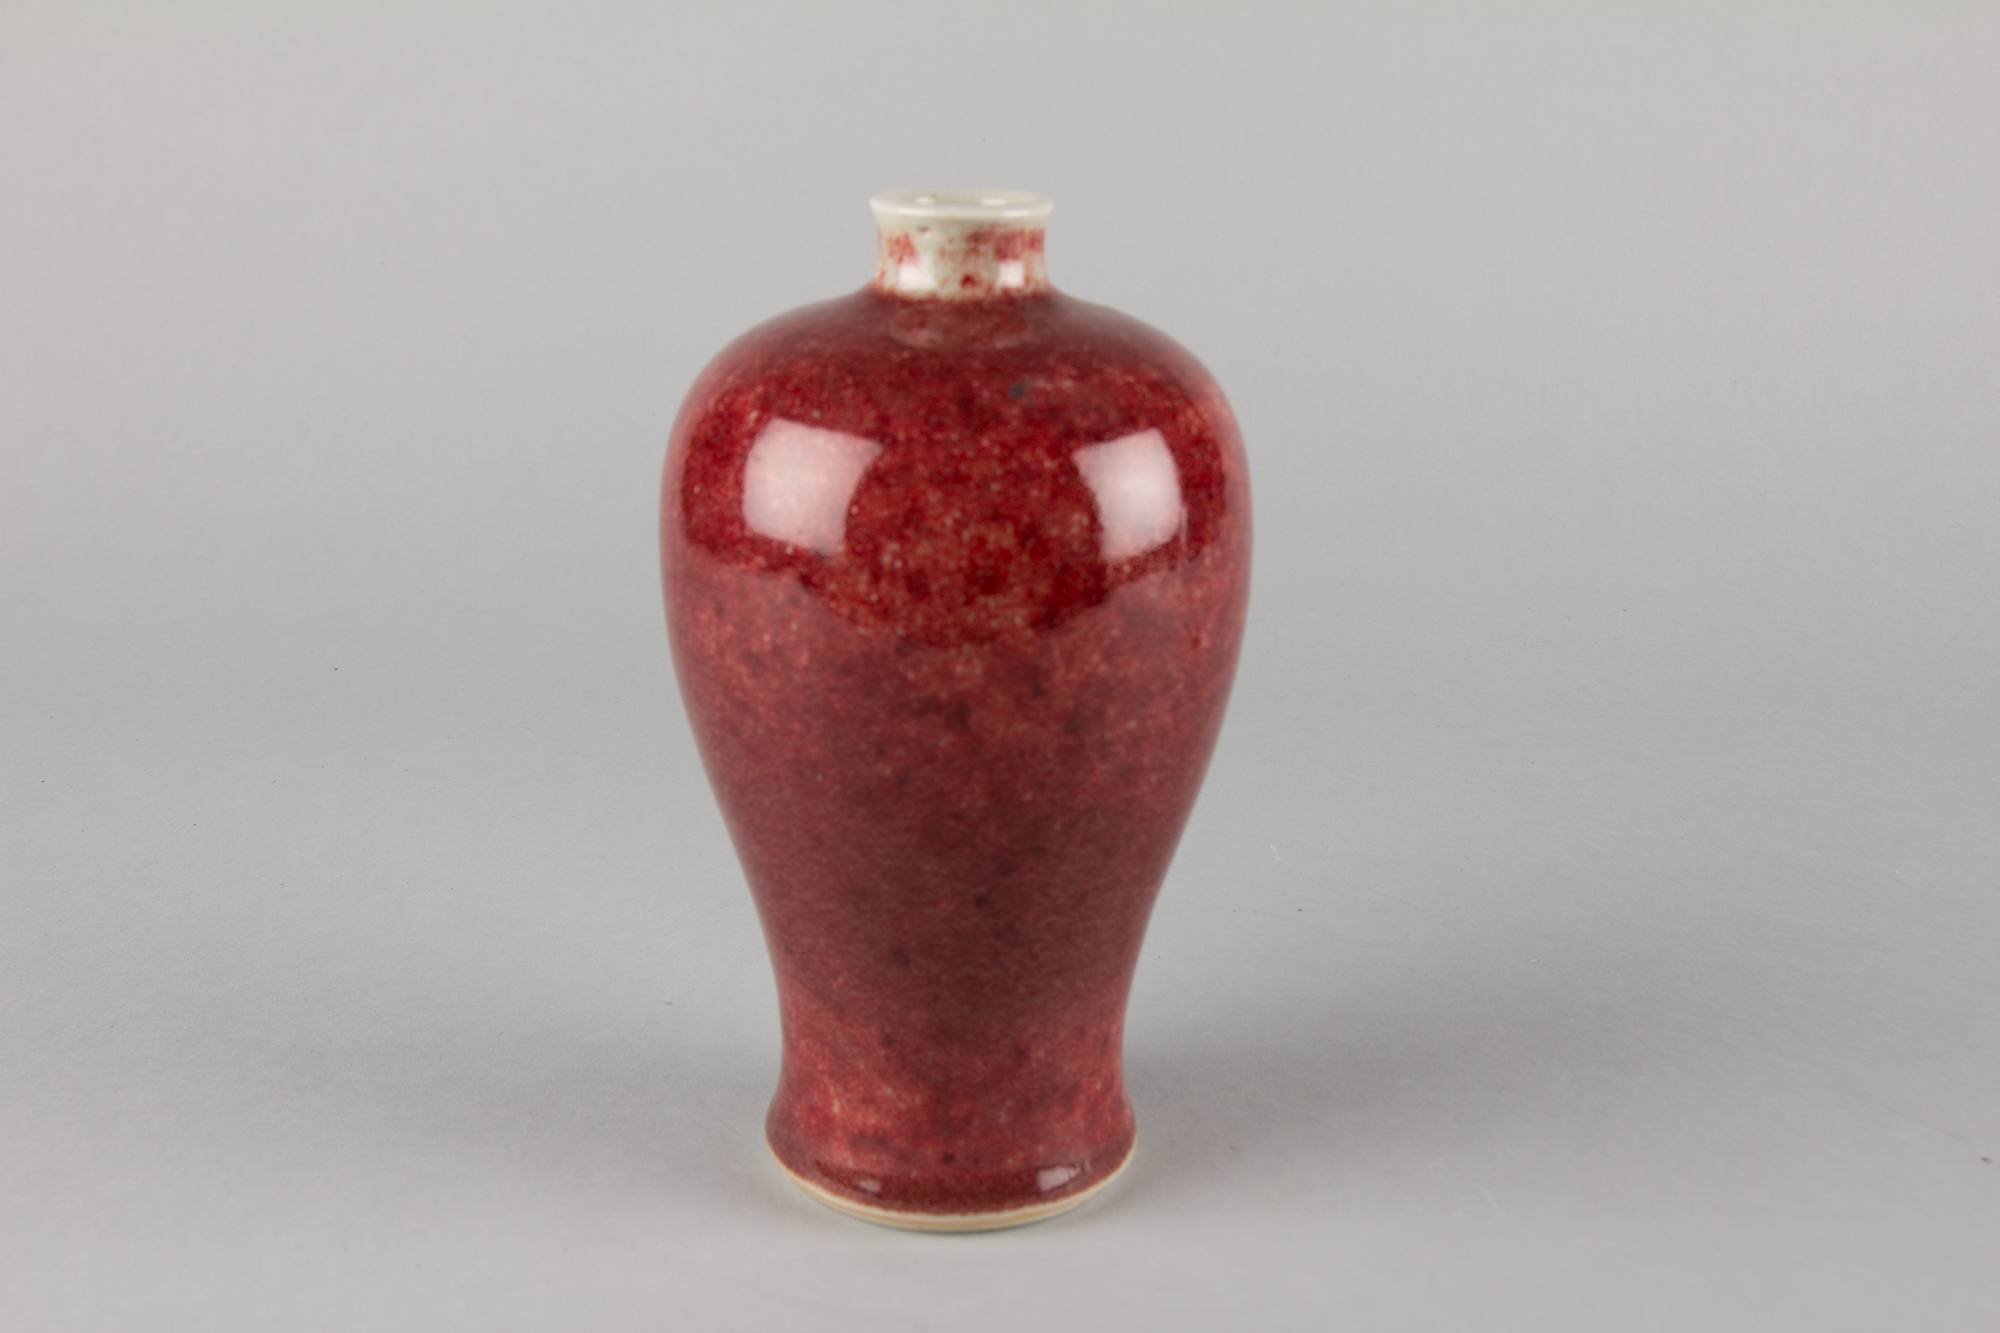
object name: gallipot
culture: chinese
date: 1662-1722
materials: porcelain